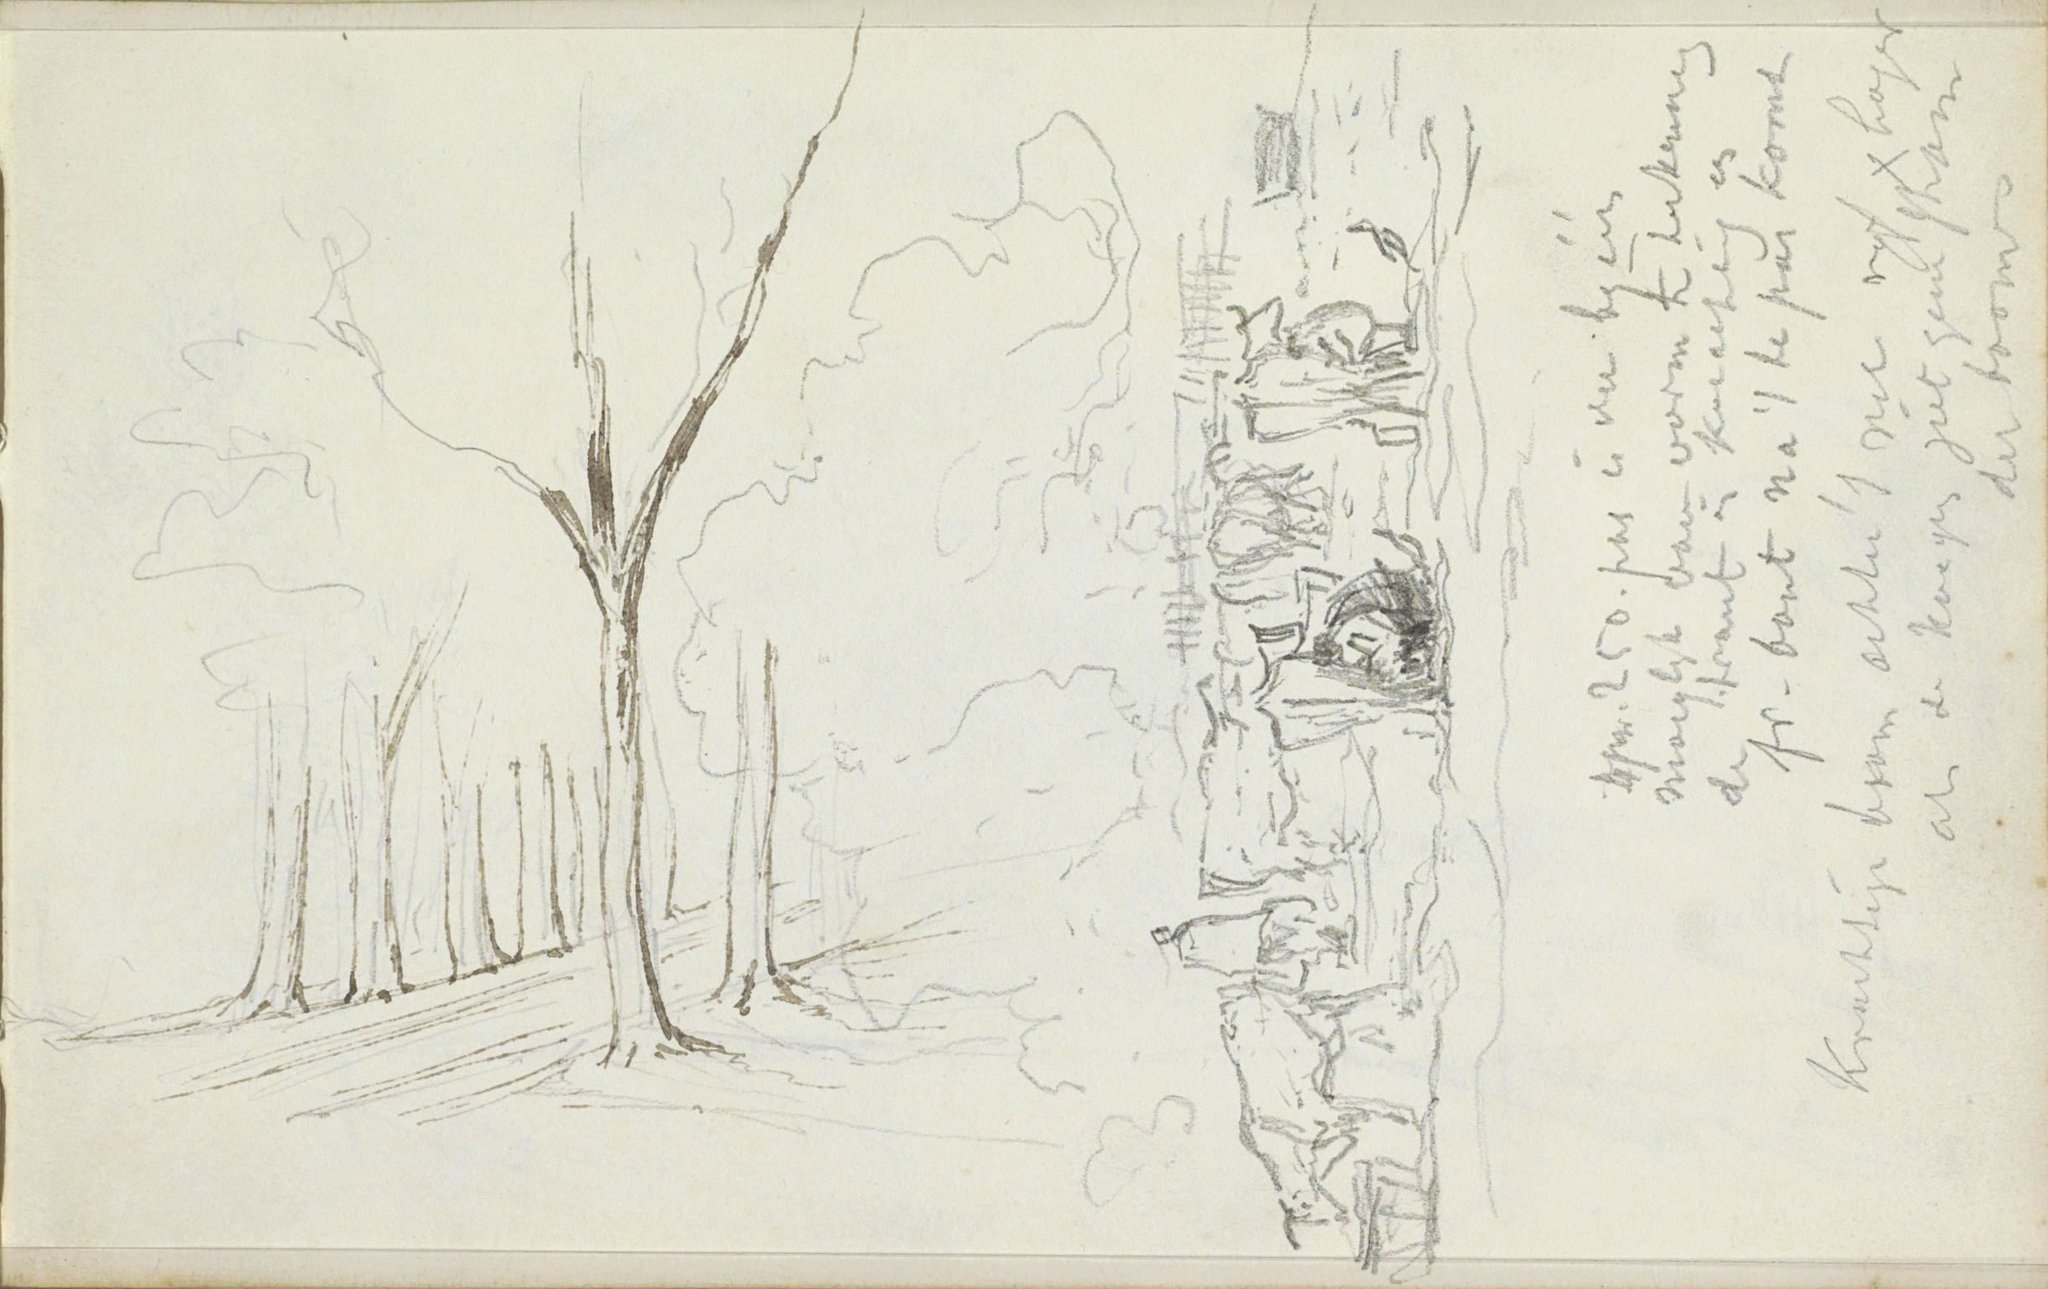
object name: sketchbook leaf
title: Bospad en figuren die koeien melken en voer geven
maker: johannes tavenraat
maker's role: draughtsman, painter, print maker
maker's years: 1809-1881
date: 1843-1844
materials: ink, paper, pencil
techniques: pen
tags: cow, forest path or lane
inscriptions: kleurnotitie, handgeschreven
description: Blad 38 recto uit een schetsboek met 38 bladen.